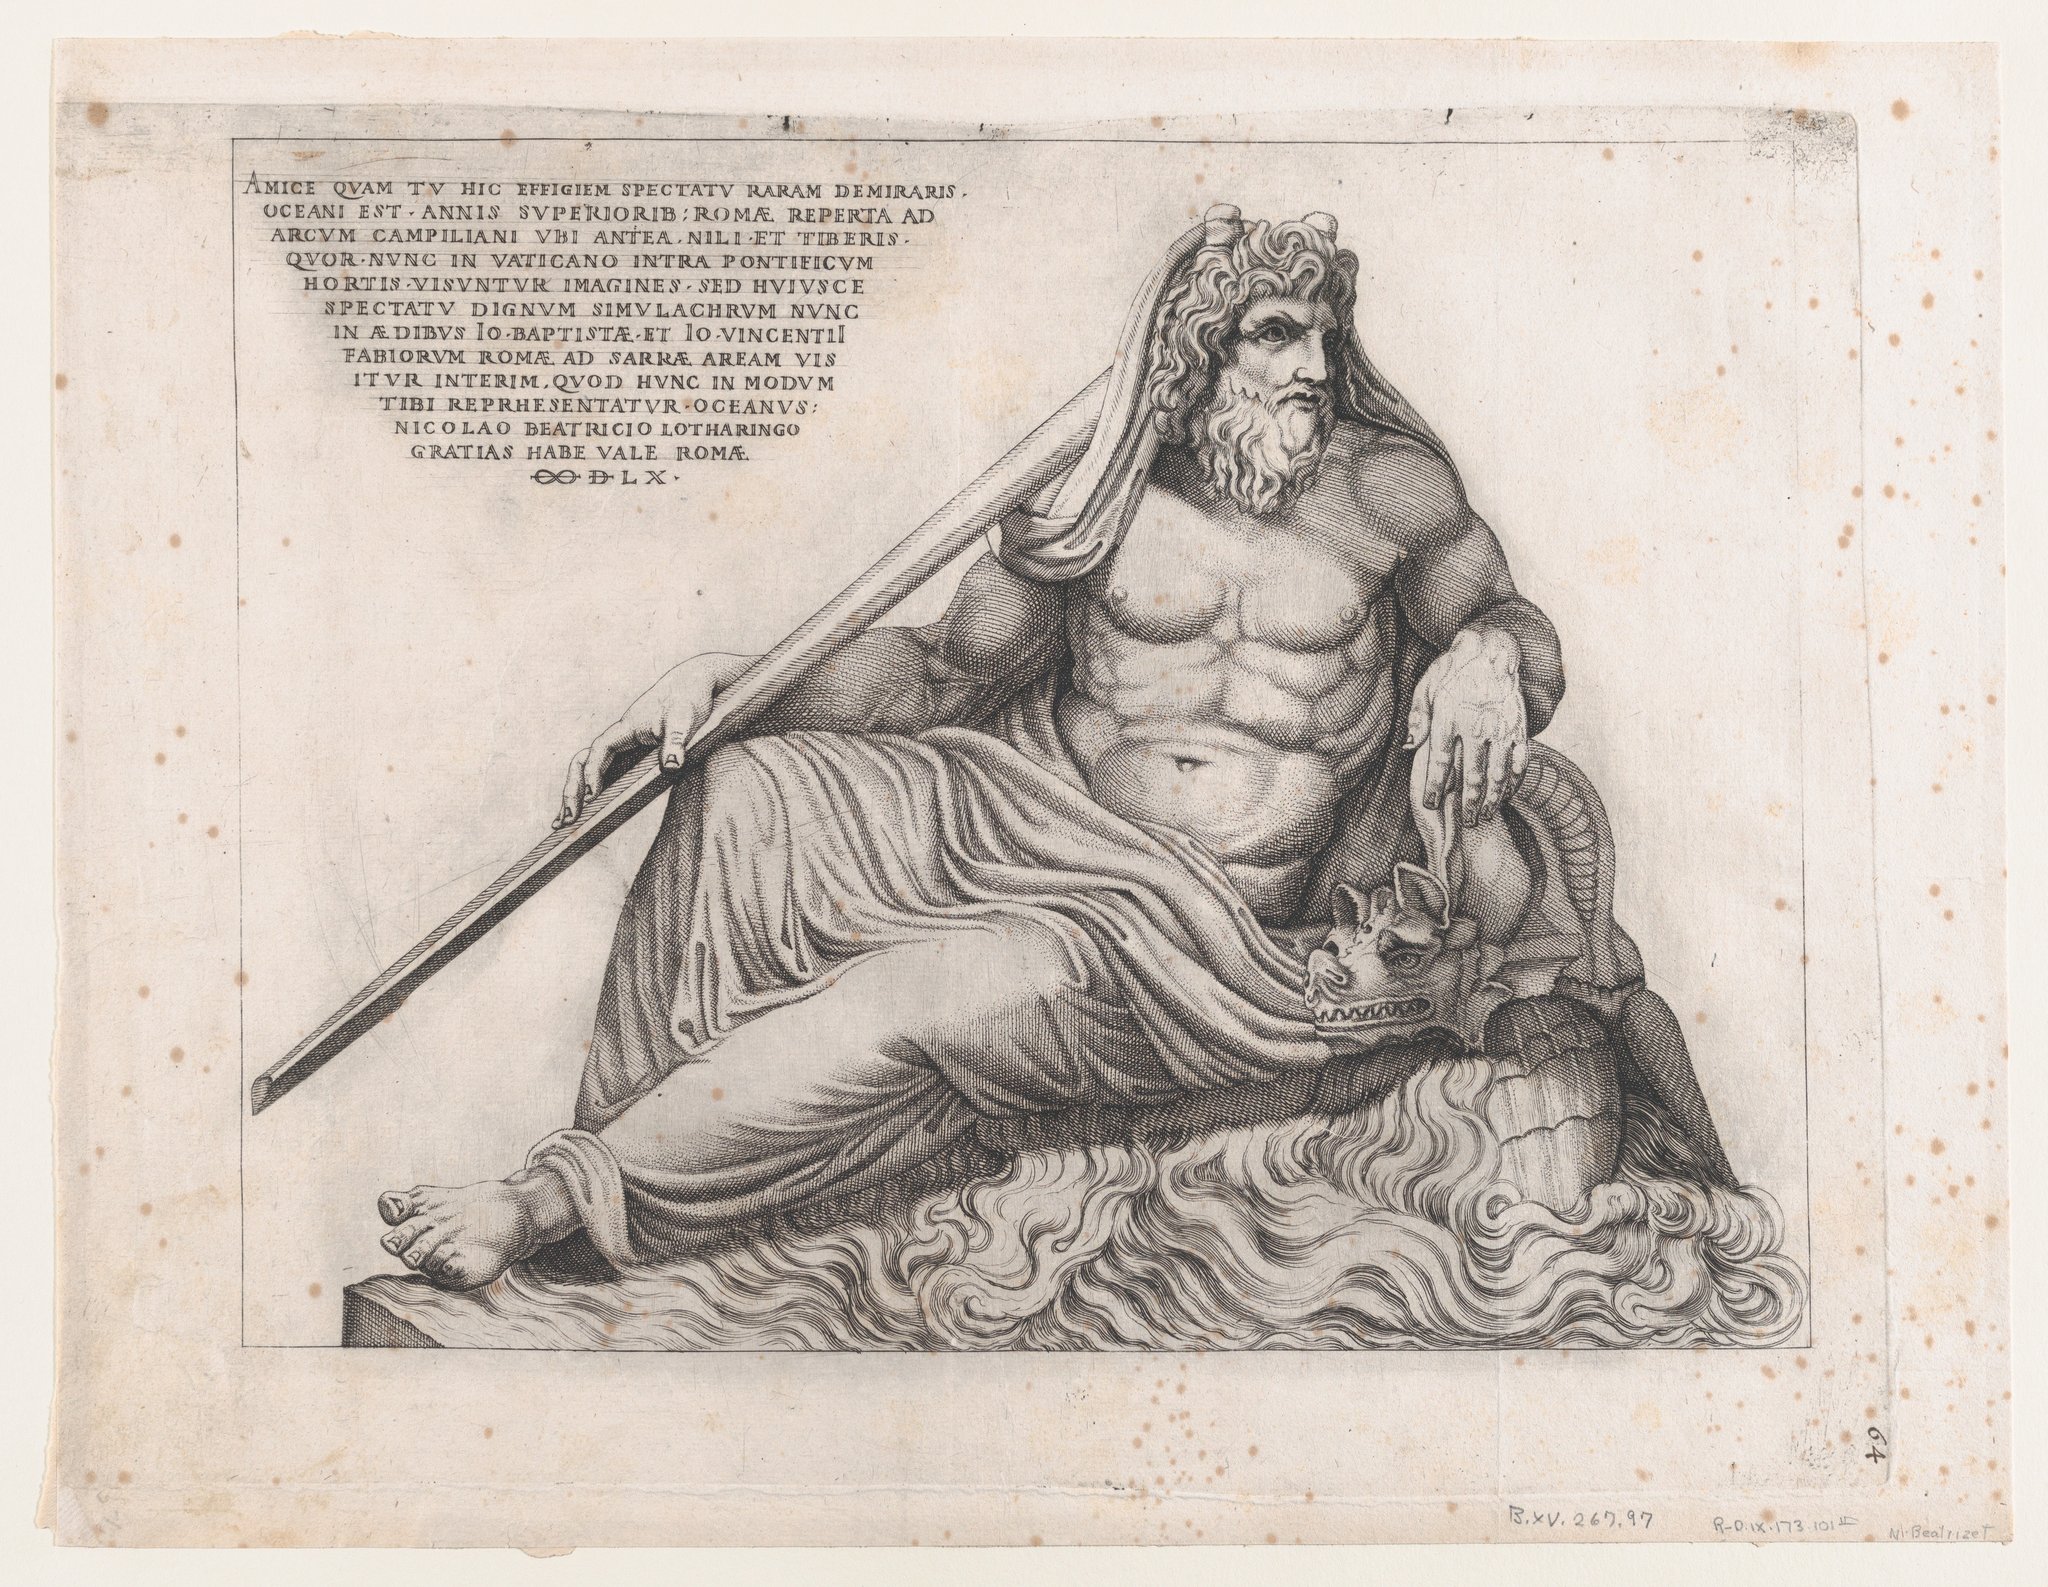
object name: print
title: The Ocean God, from "Speculum Romanae Magnificentiae"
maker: nicolas beatrizet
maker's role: artist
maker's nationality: french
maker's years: 1515-1566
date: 1560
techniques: engraving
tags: men,gods